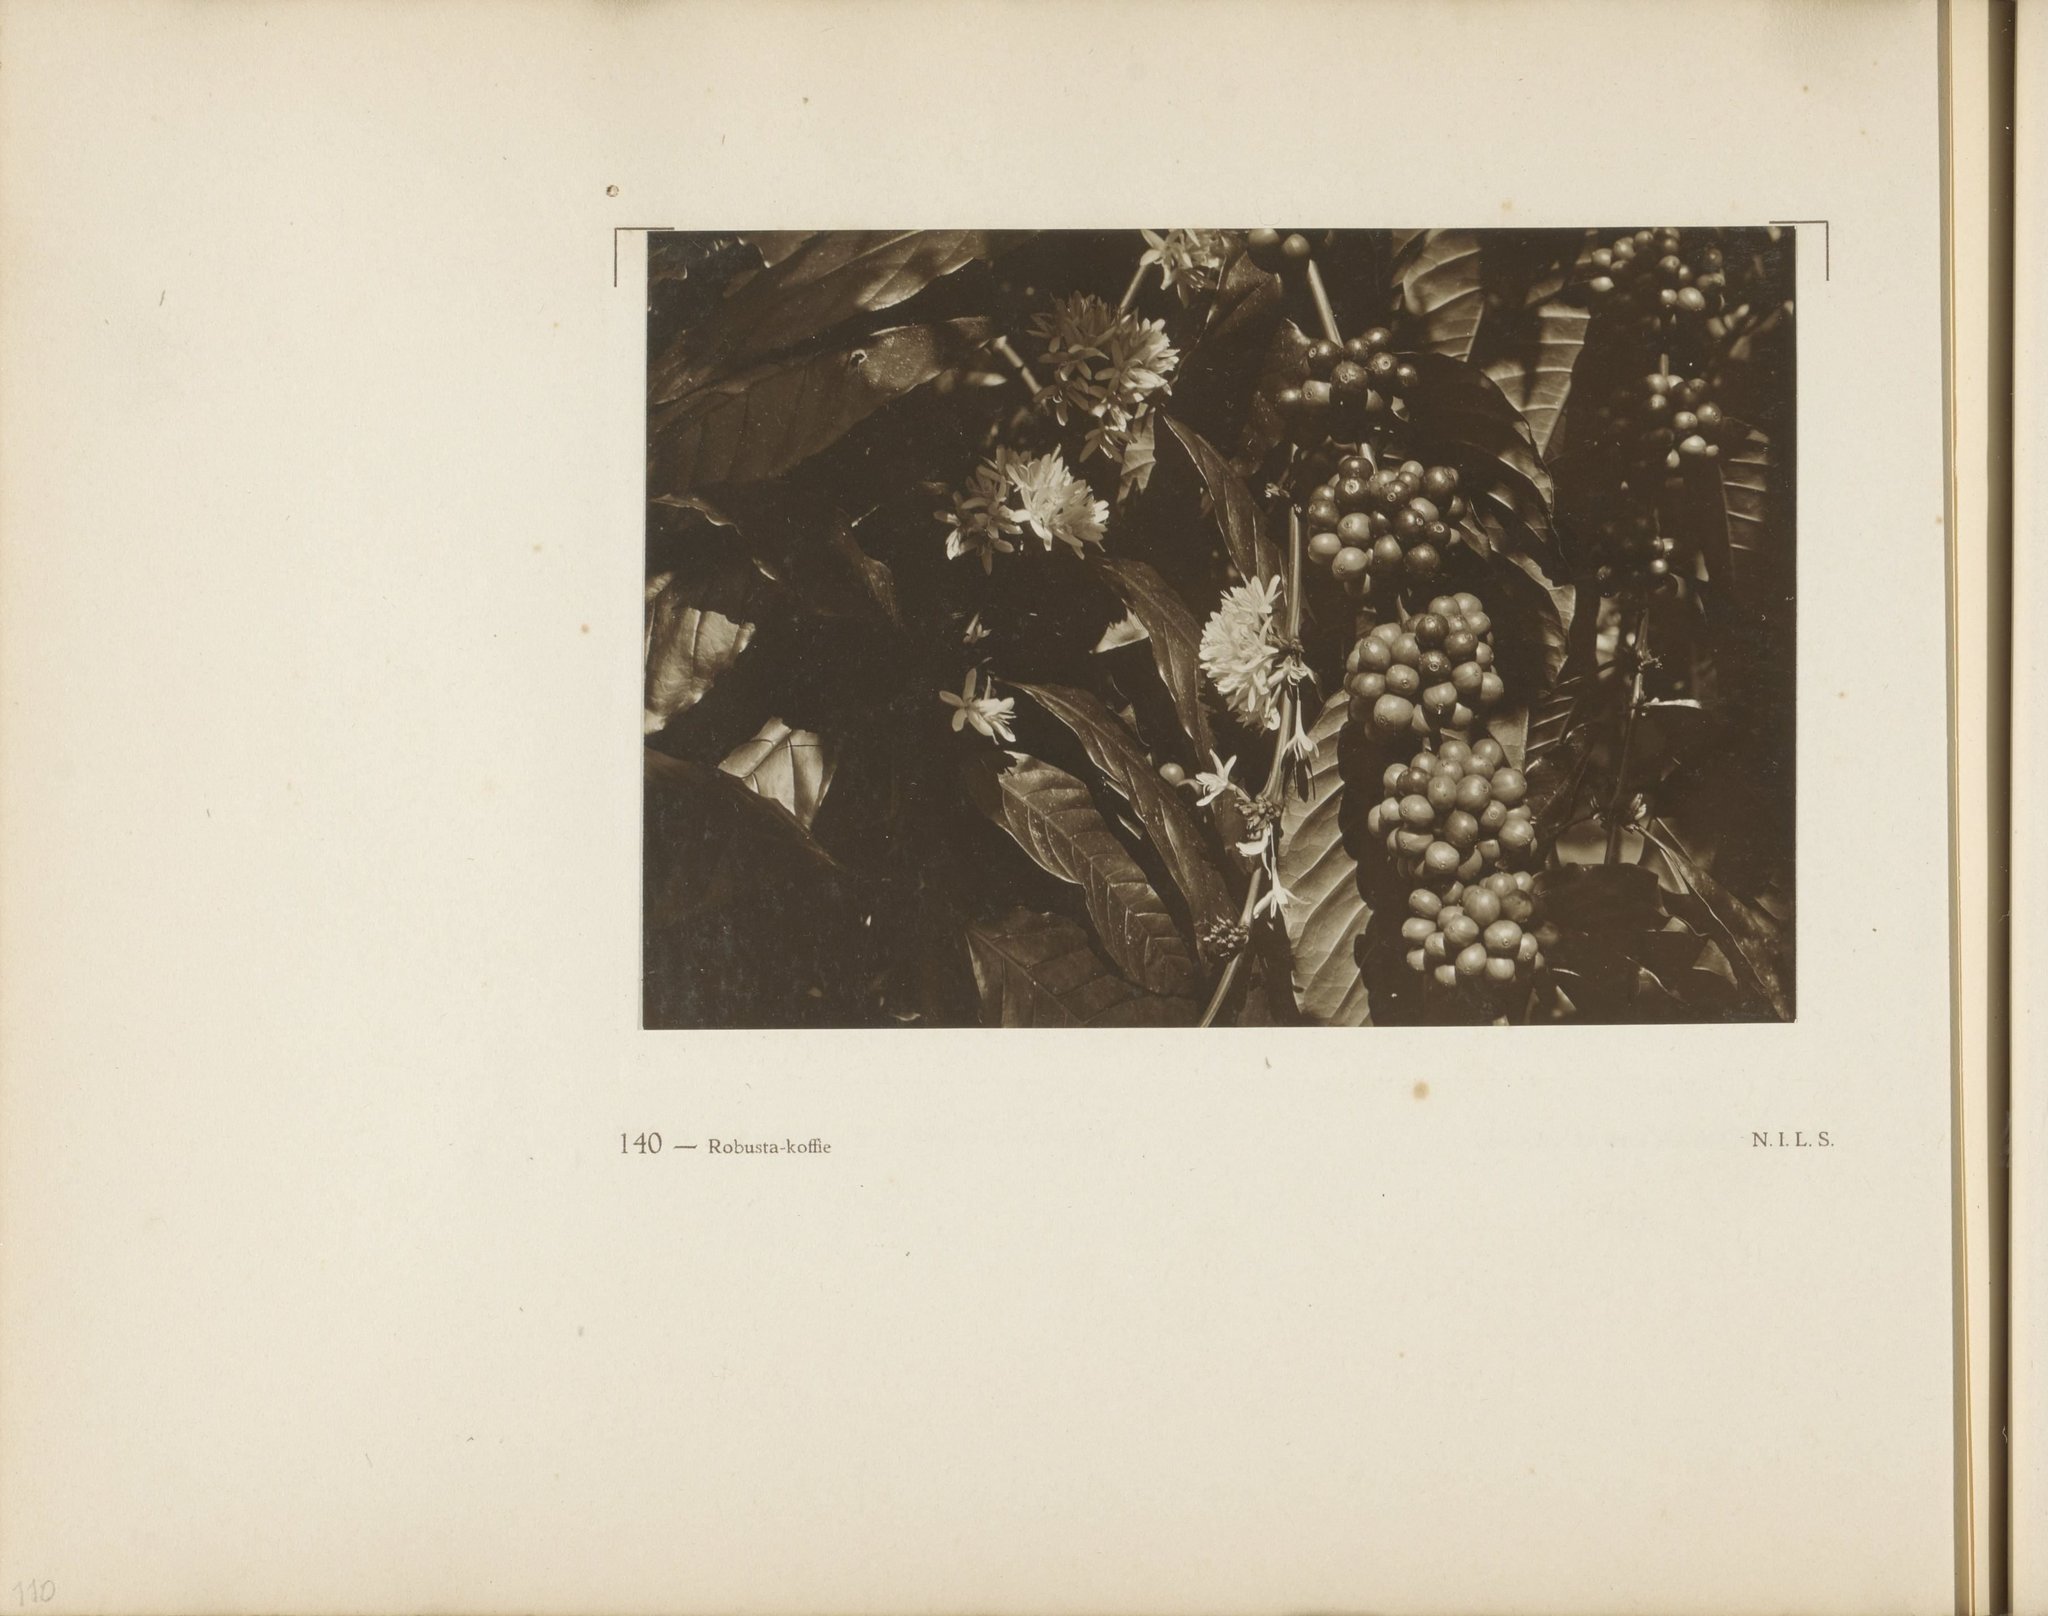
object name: album leaf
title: Pagina 140 van fotoboek van de Algemeene Vereeniging van Rubberplanters ter Oostkust van Sumatra (A.V.R.O.S.)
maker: j.w. meyster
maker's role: fotograaf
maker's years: 1887-1945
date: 1924-1925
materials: paper, photographic support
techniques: printing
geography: dutch east indies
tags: plants; vegetation, coffee, (non-fruit) products of plants or trees: rubber, sumatra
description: Boekpagina met een foto van een Robusta-koffieplant met bonen op Sumatra (Nederlandsch-Indisch Land Syndicaat). Onderdeel van een fotoboek van de Algemeene Vereeniging van Rubberplanters ter Oostkust van Sumatra (A.V.R.O.S.).